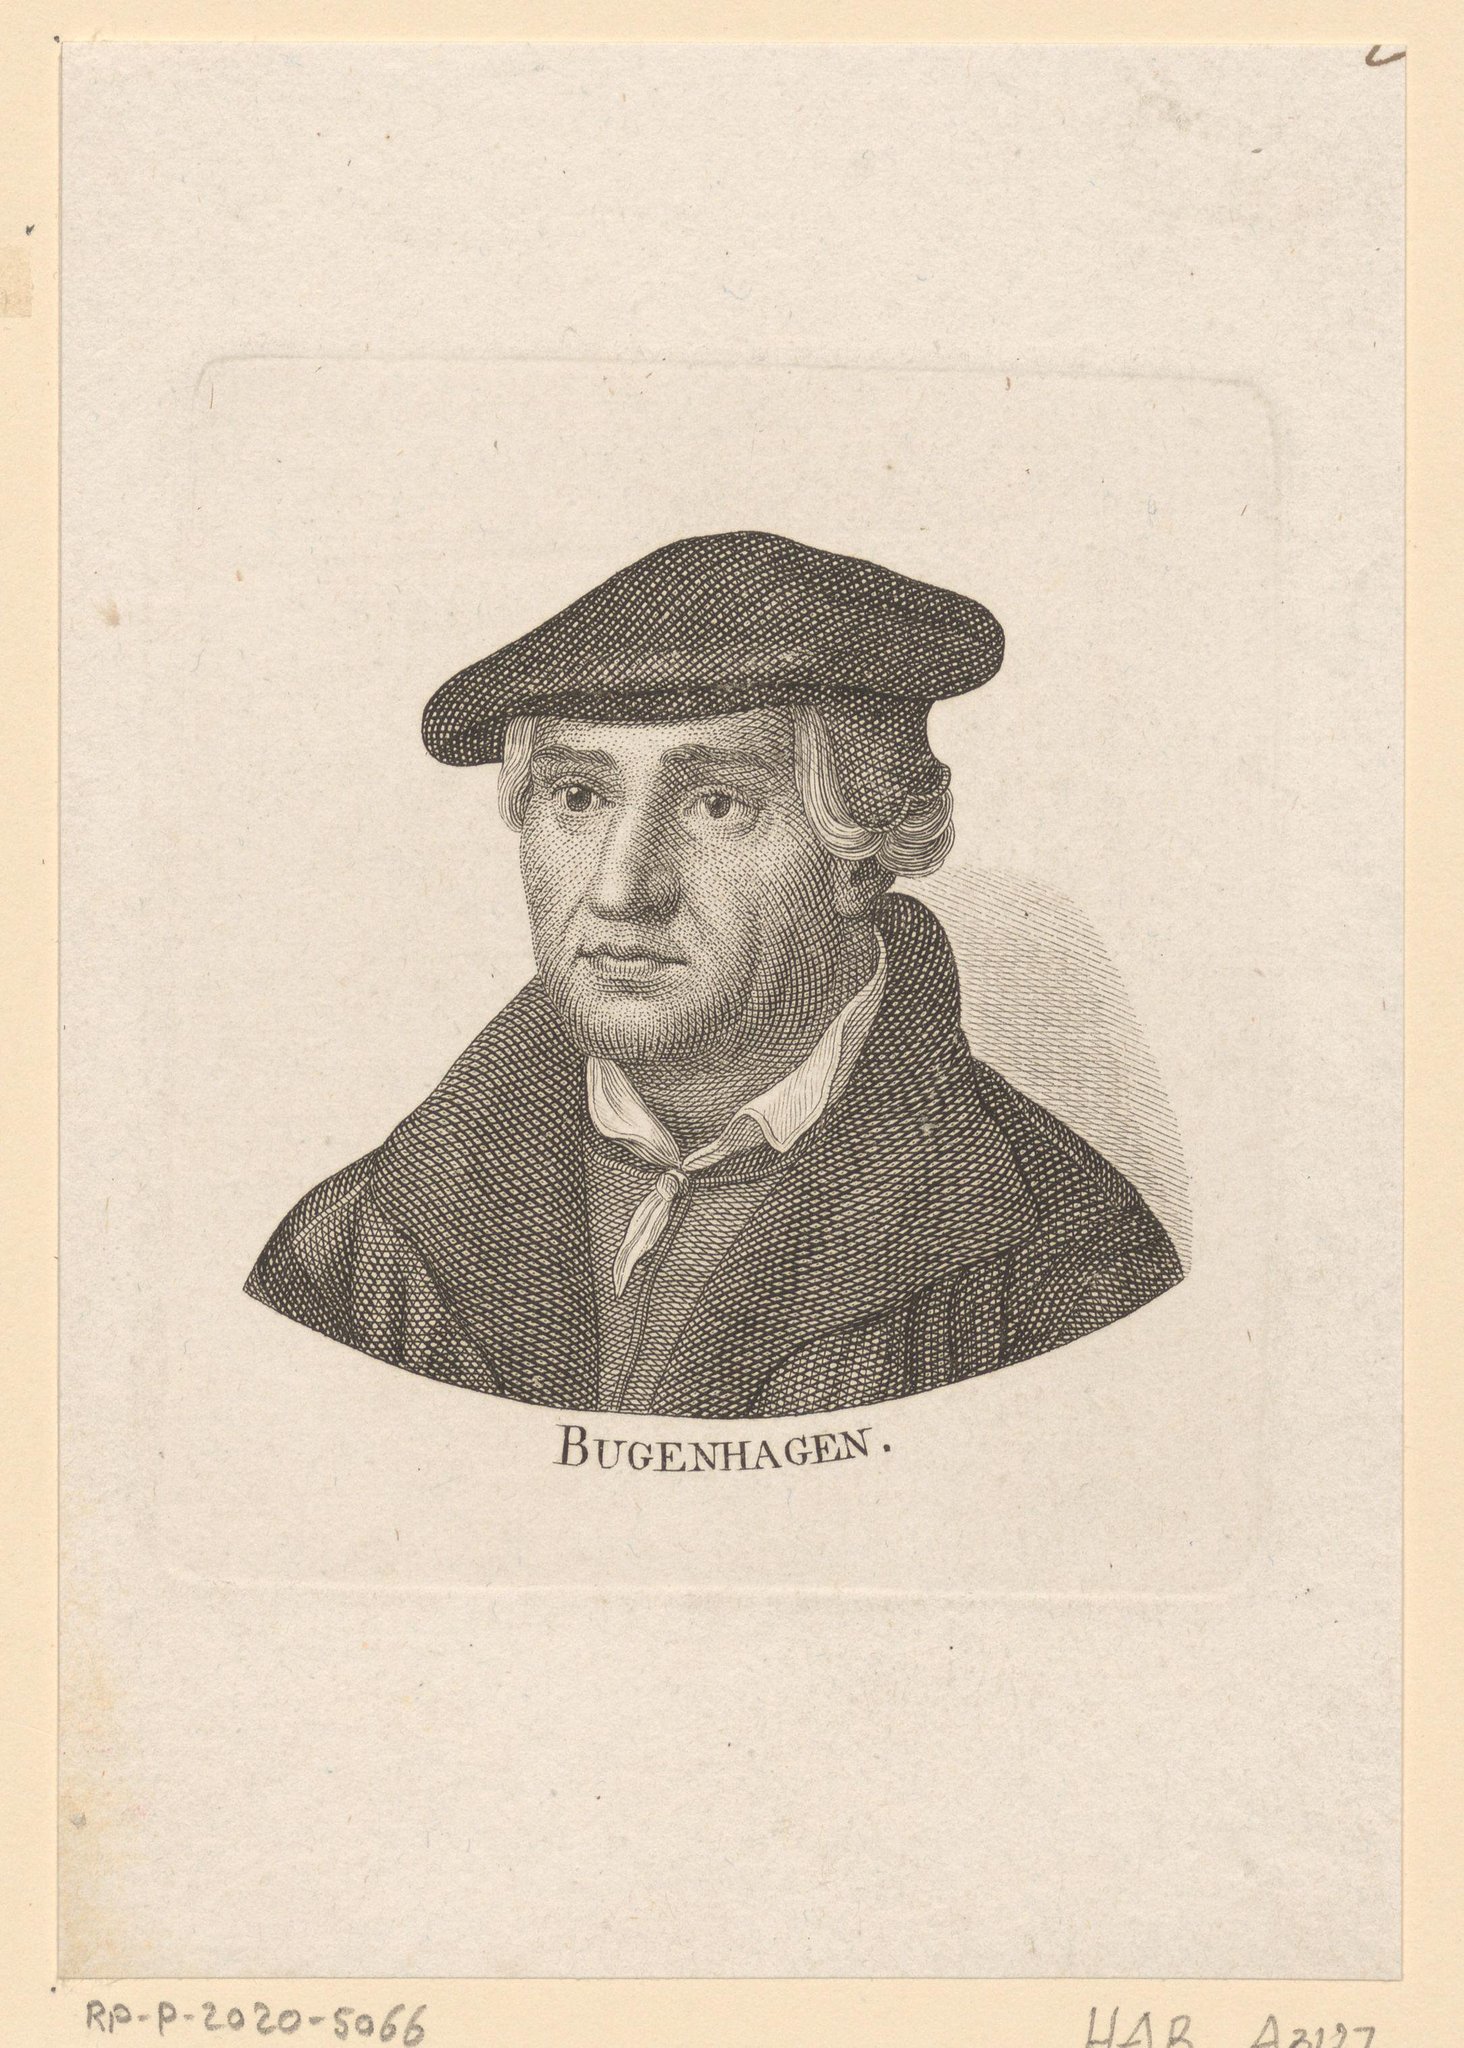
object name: print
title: Portret van Johannes Bugenhagen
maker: ernst ludwig riepenhausen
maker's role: print maker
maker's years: 1765-1840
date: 1775-1840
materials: paper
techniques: engraving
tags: theologian, historical persons